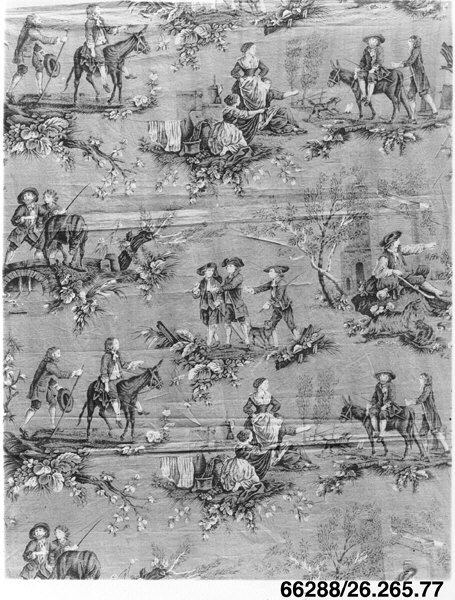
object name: furnishing textile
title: Pictorial print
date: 1834-1866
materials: cotton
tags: men,women,horses,flowers,trees